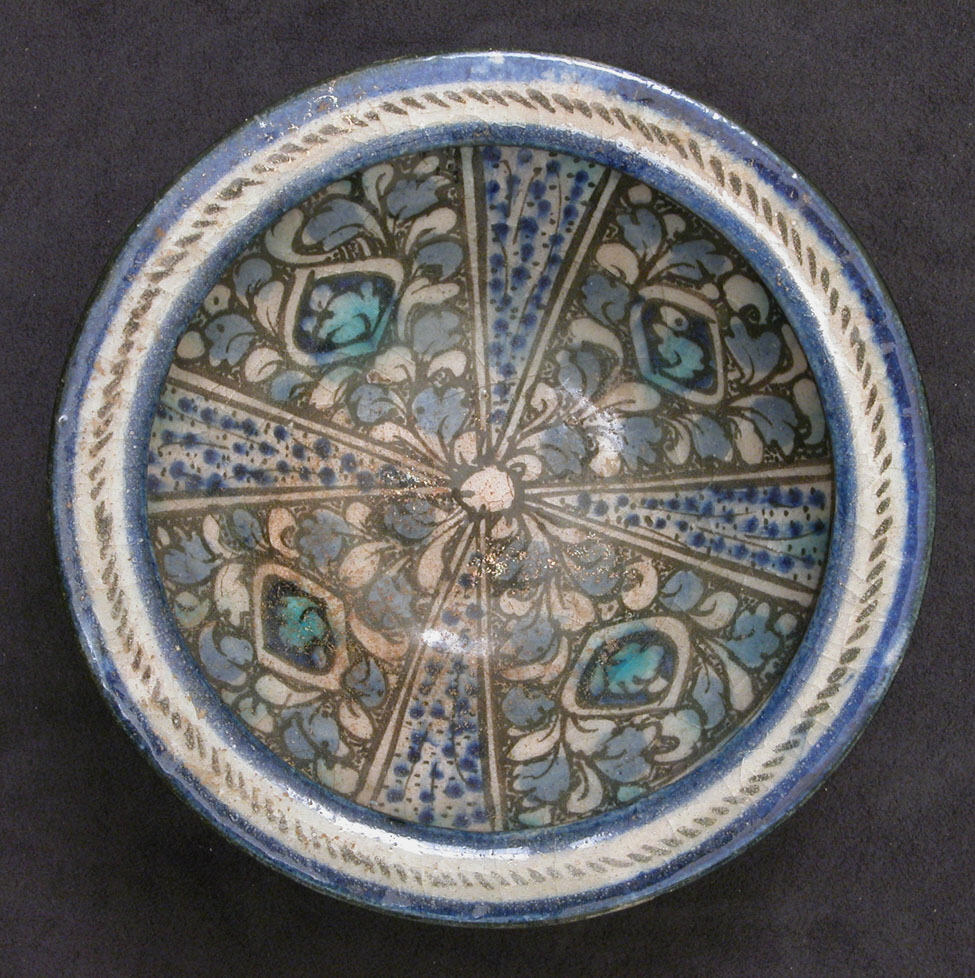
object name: bowl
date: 1301-1400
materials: stonepaste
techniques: painting, underglaze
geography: iran